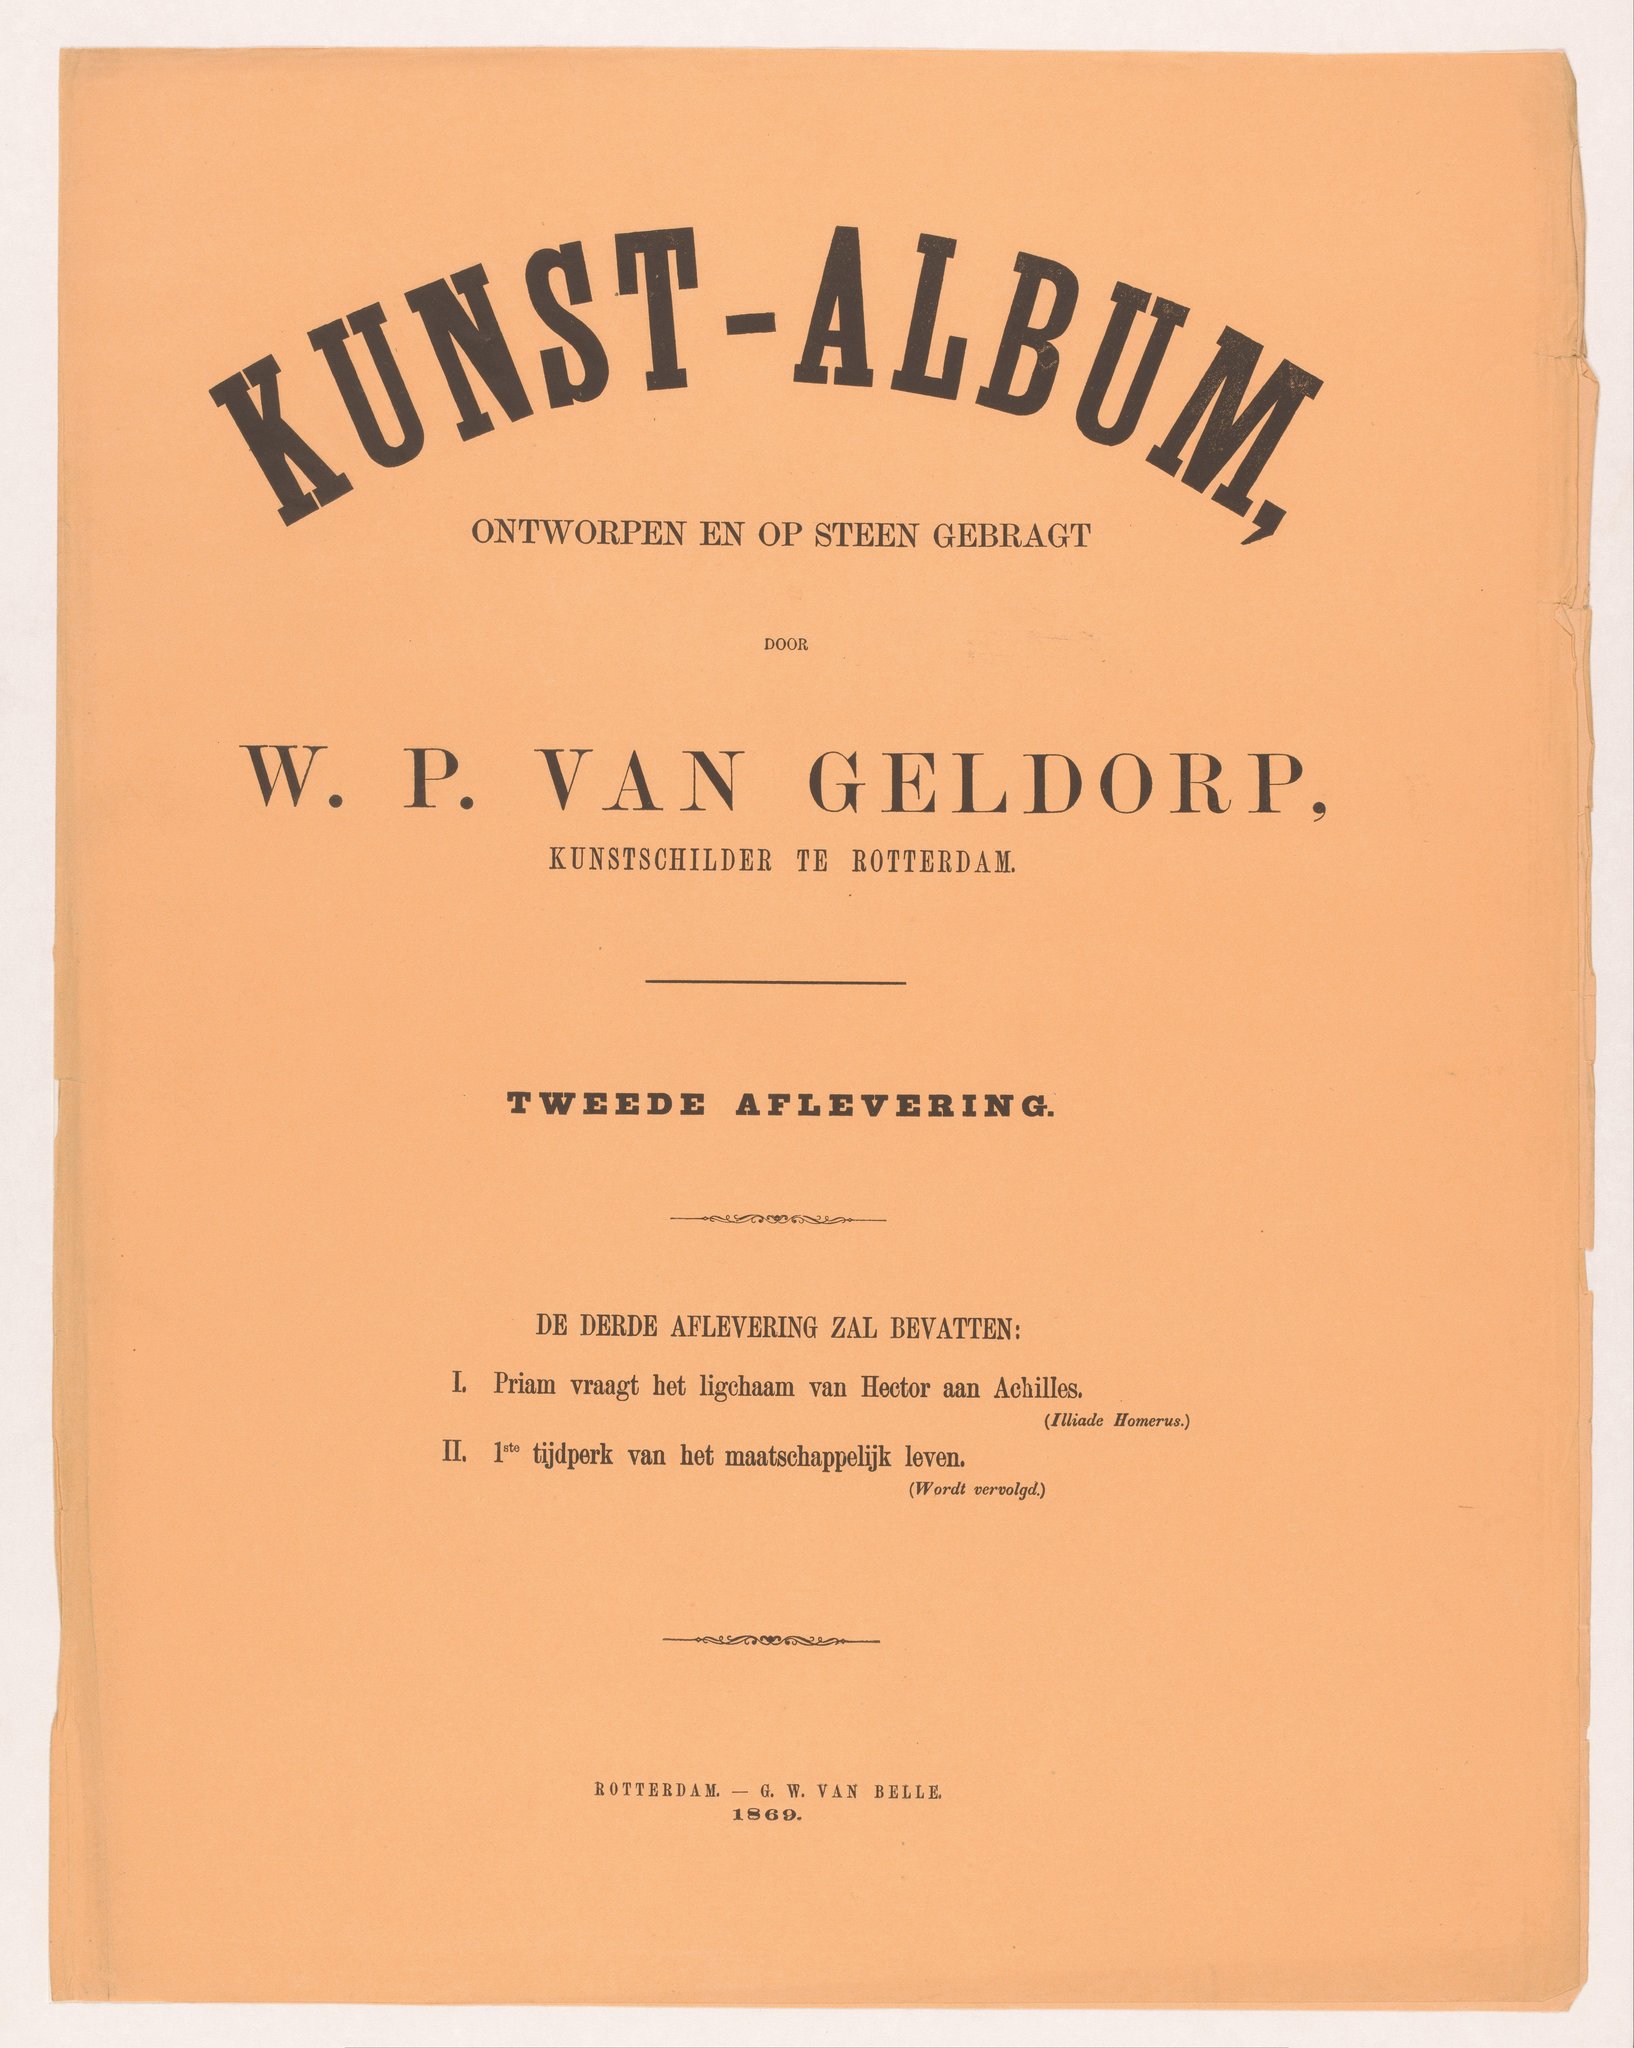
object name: print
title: Kunst-Album door W. P. van Geldorp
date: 1869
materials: paper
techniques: lithograph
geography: rotterdam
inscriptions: date